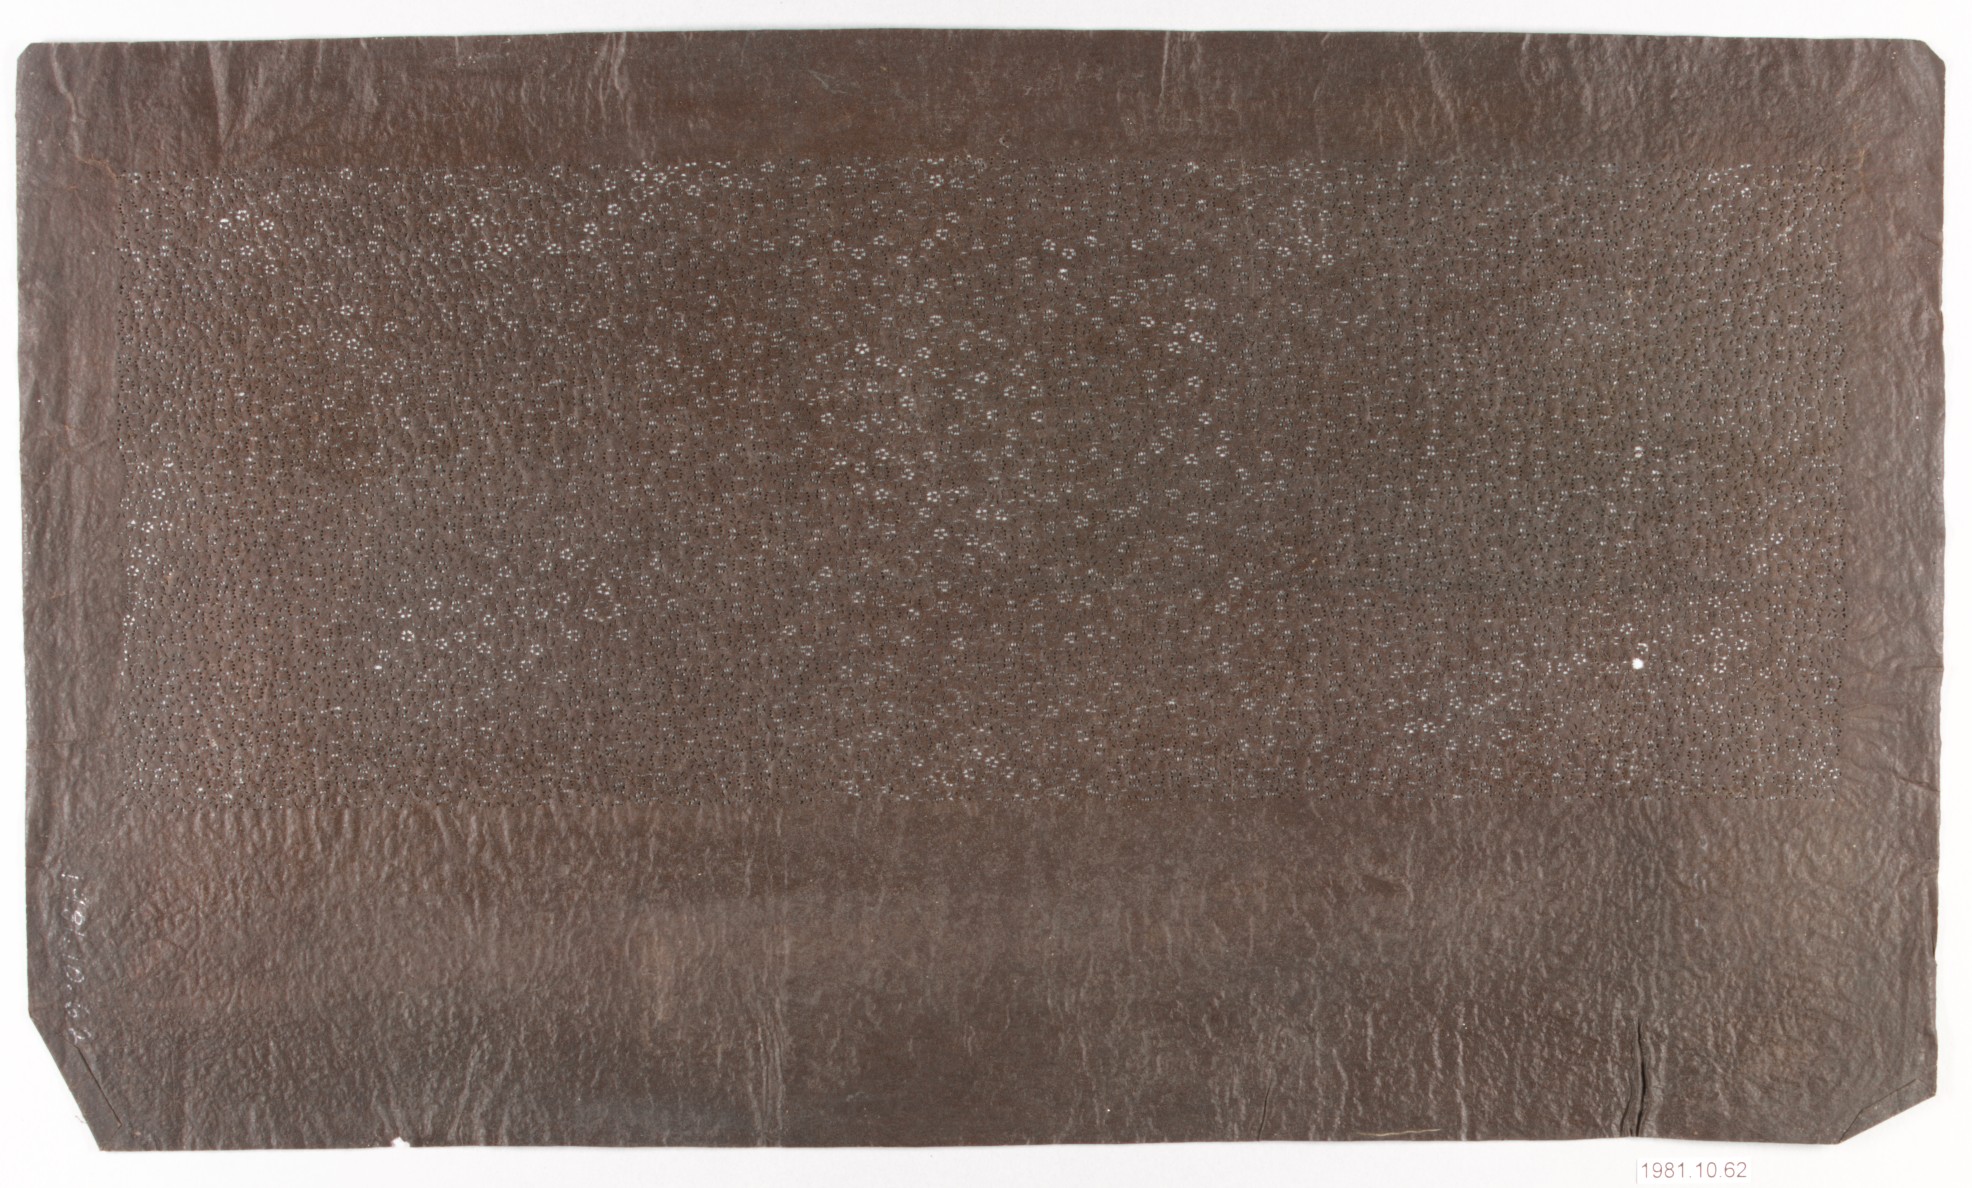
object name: stencil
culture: japanese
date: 1801-1900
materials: paper